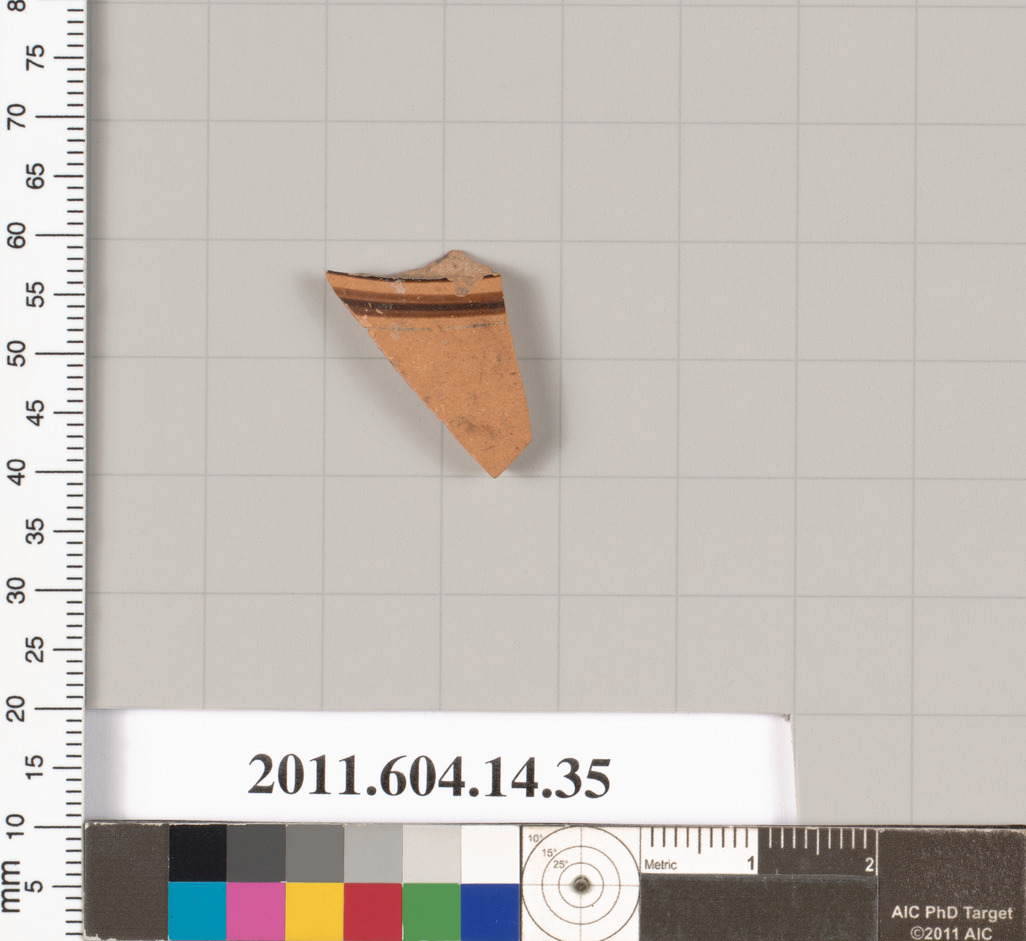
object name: kylix fragment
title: Terracotta fragment of a kylix (drinking cup)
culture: unknown fabric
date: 600-401 BCE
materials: terracotta